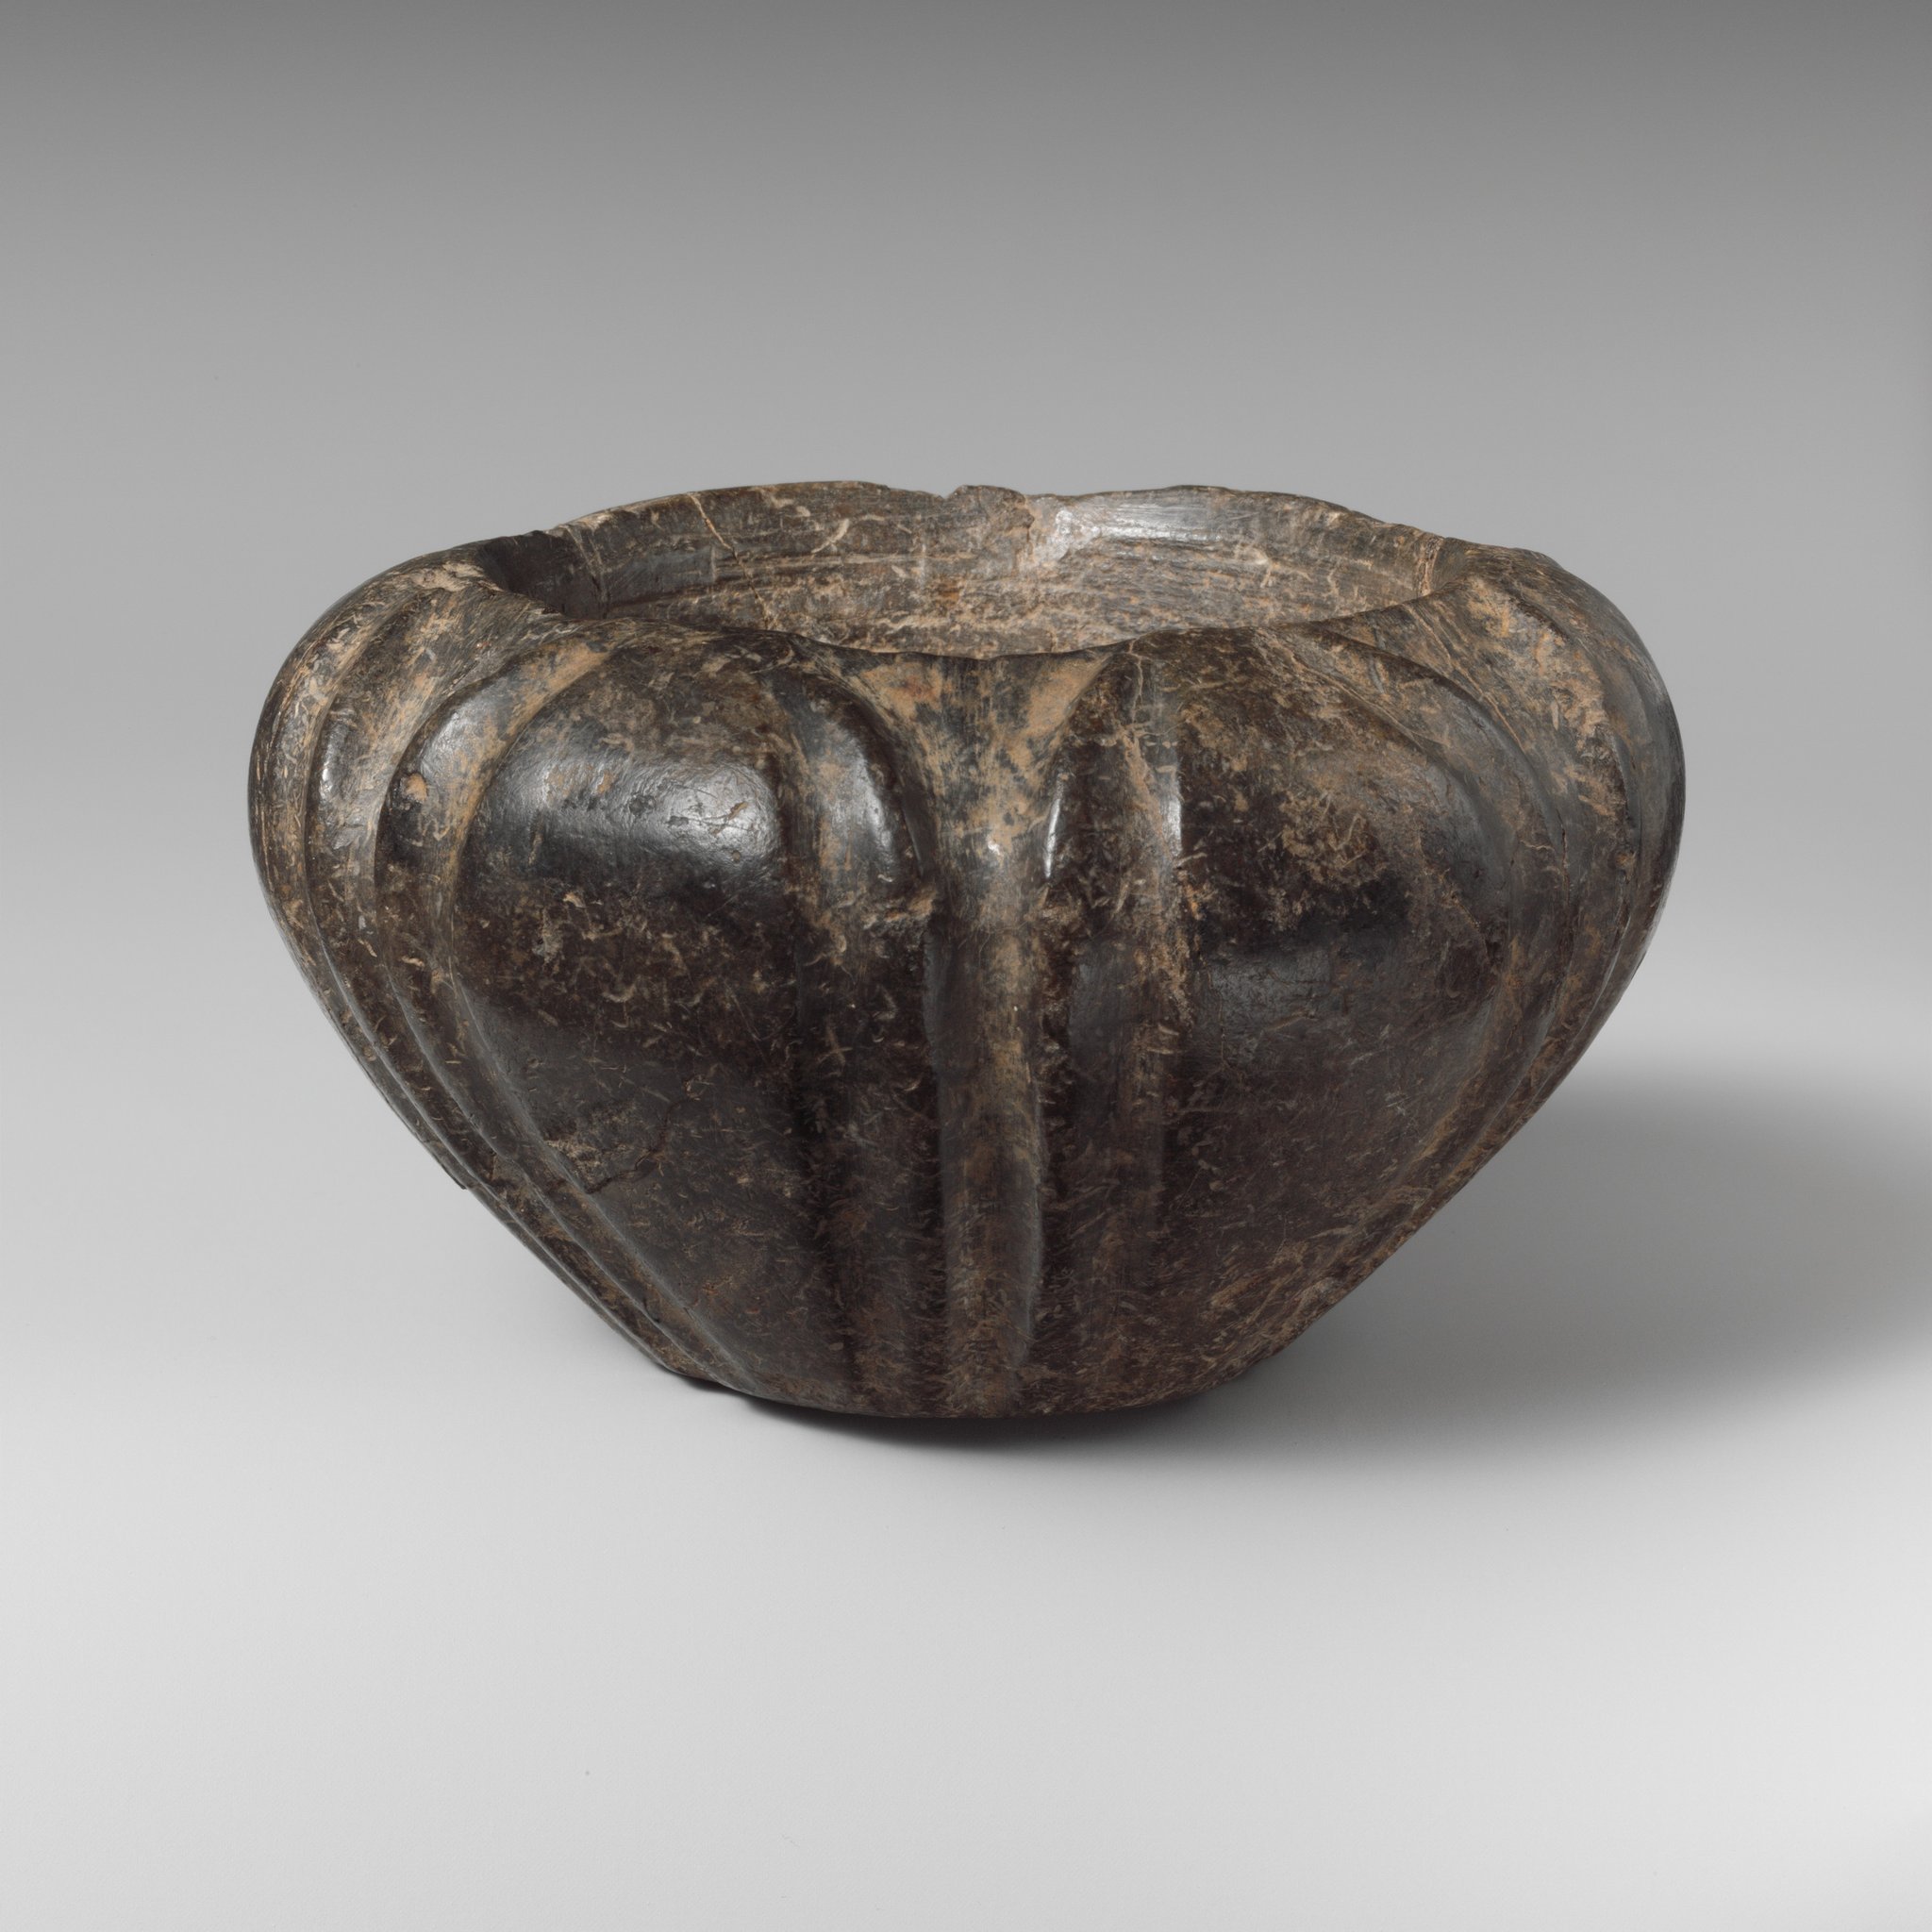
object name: blossom bowl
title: Serpentine blossom bowl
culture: minoan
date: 1750-1450 BCE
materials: stone